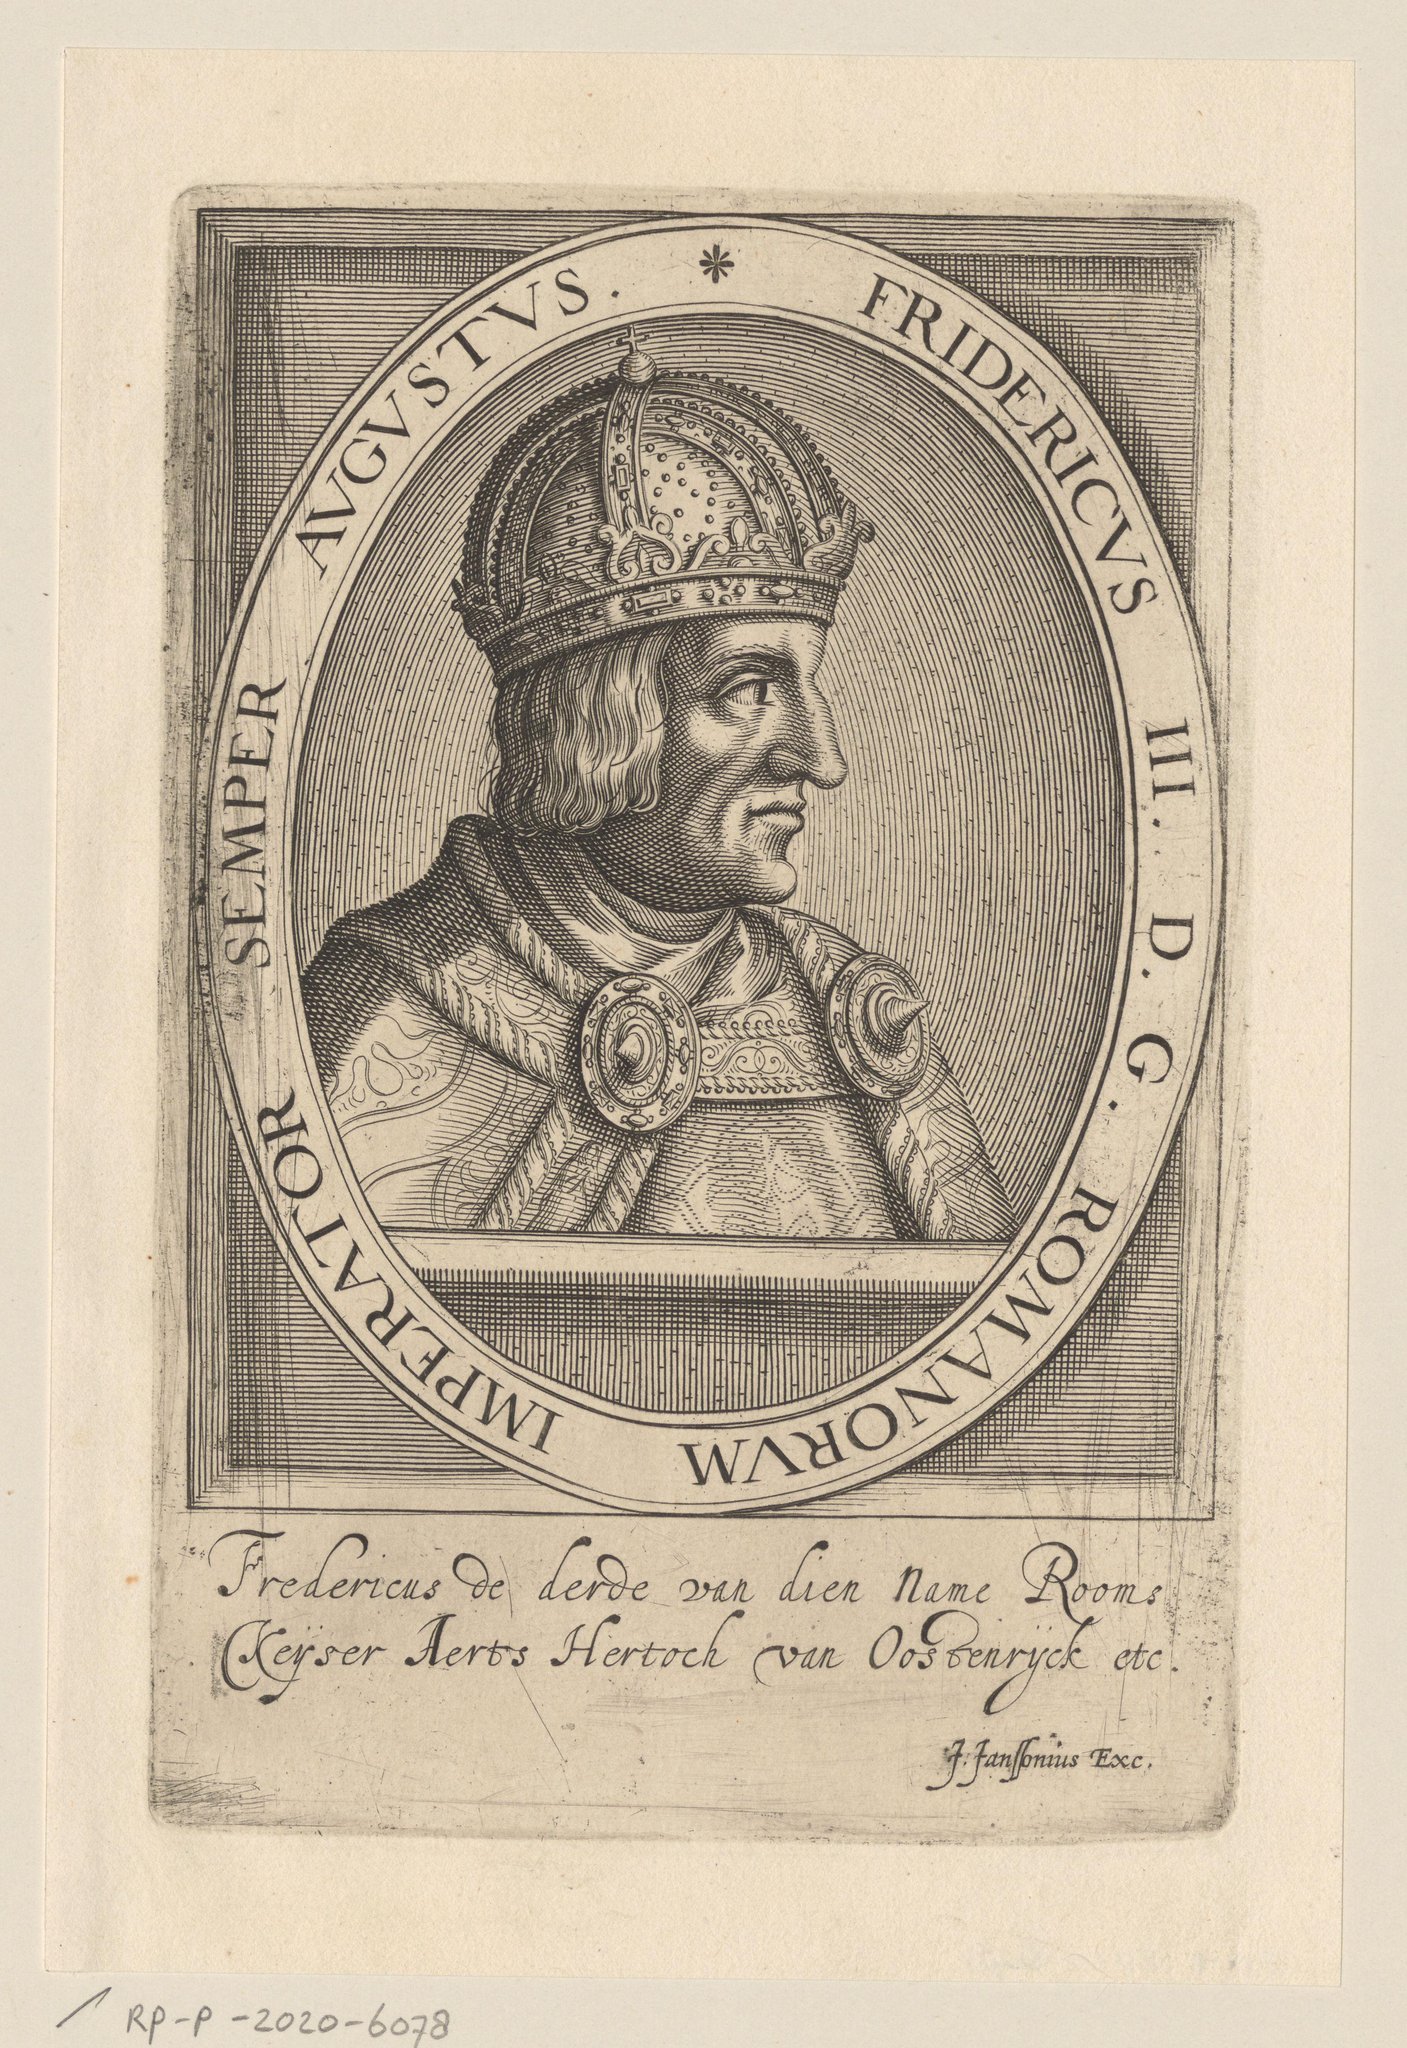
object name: print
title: Portret van keizer Frederik III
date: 1608-1665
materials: paper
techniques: engraving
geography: amsterdam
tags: crown (symbol of sovereignty), historical persons, emperor